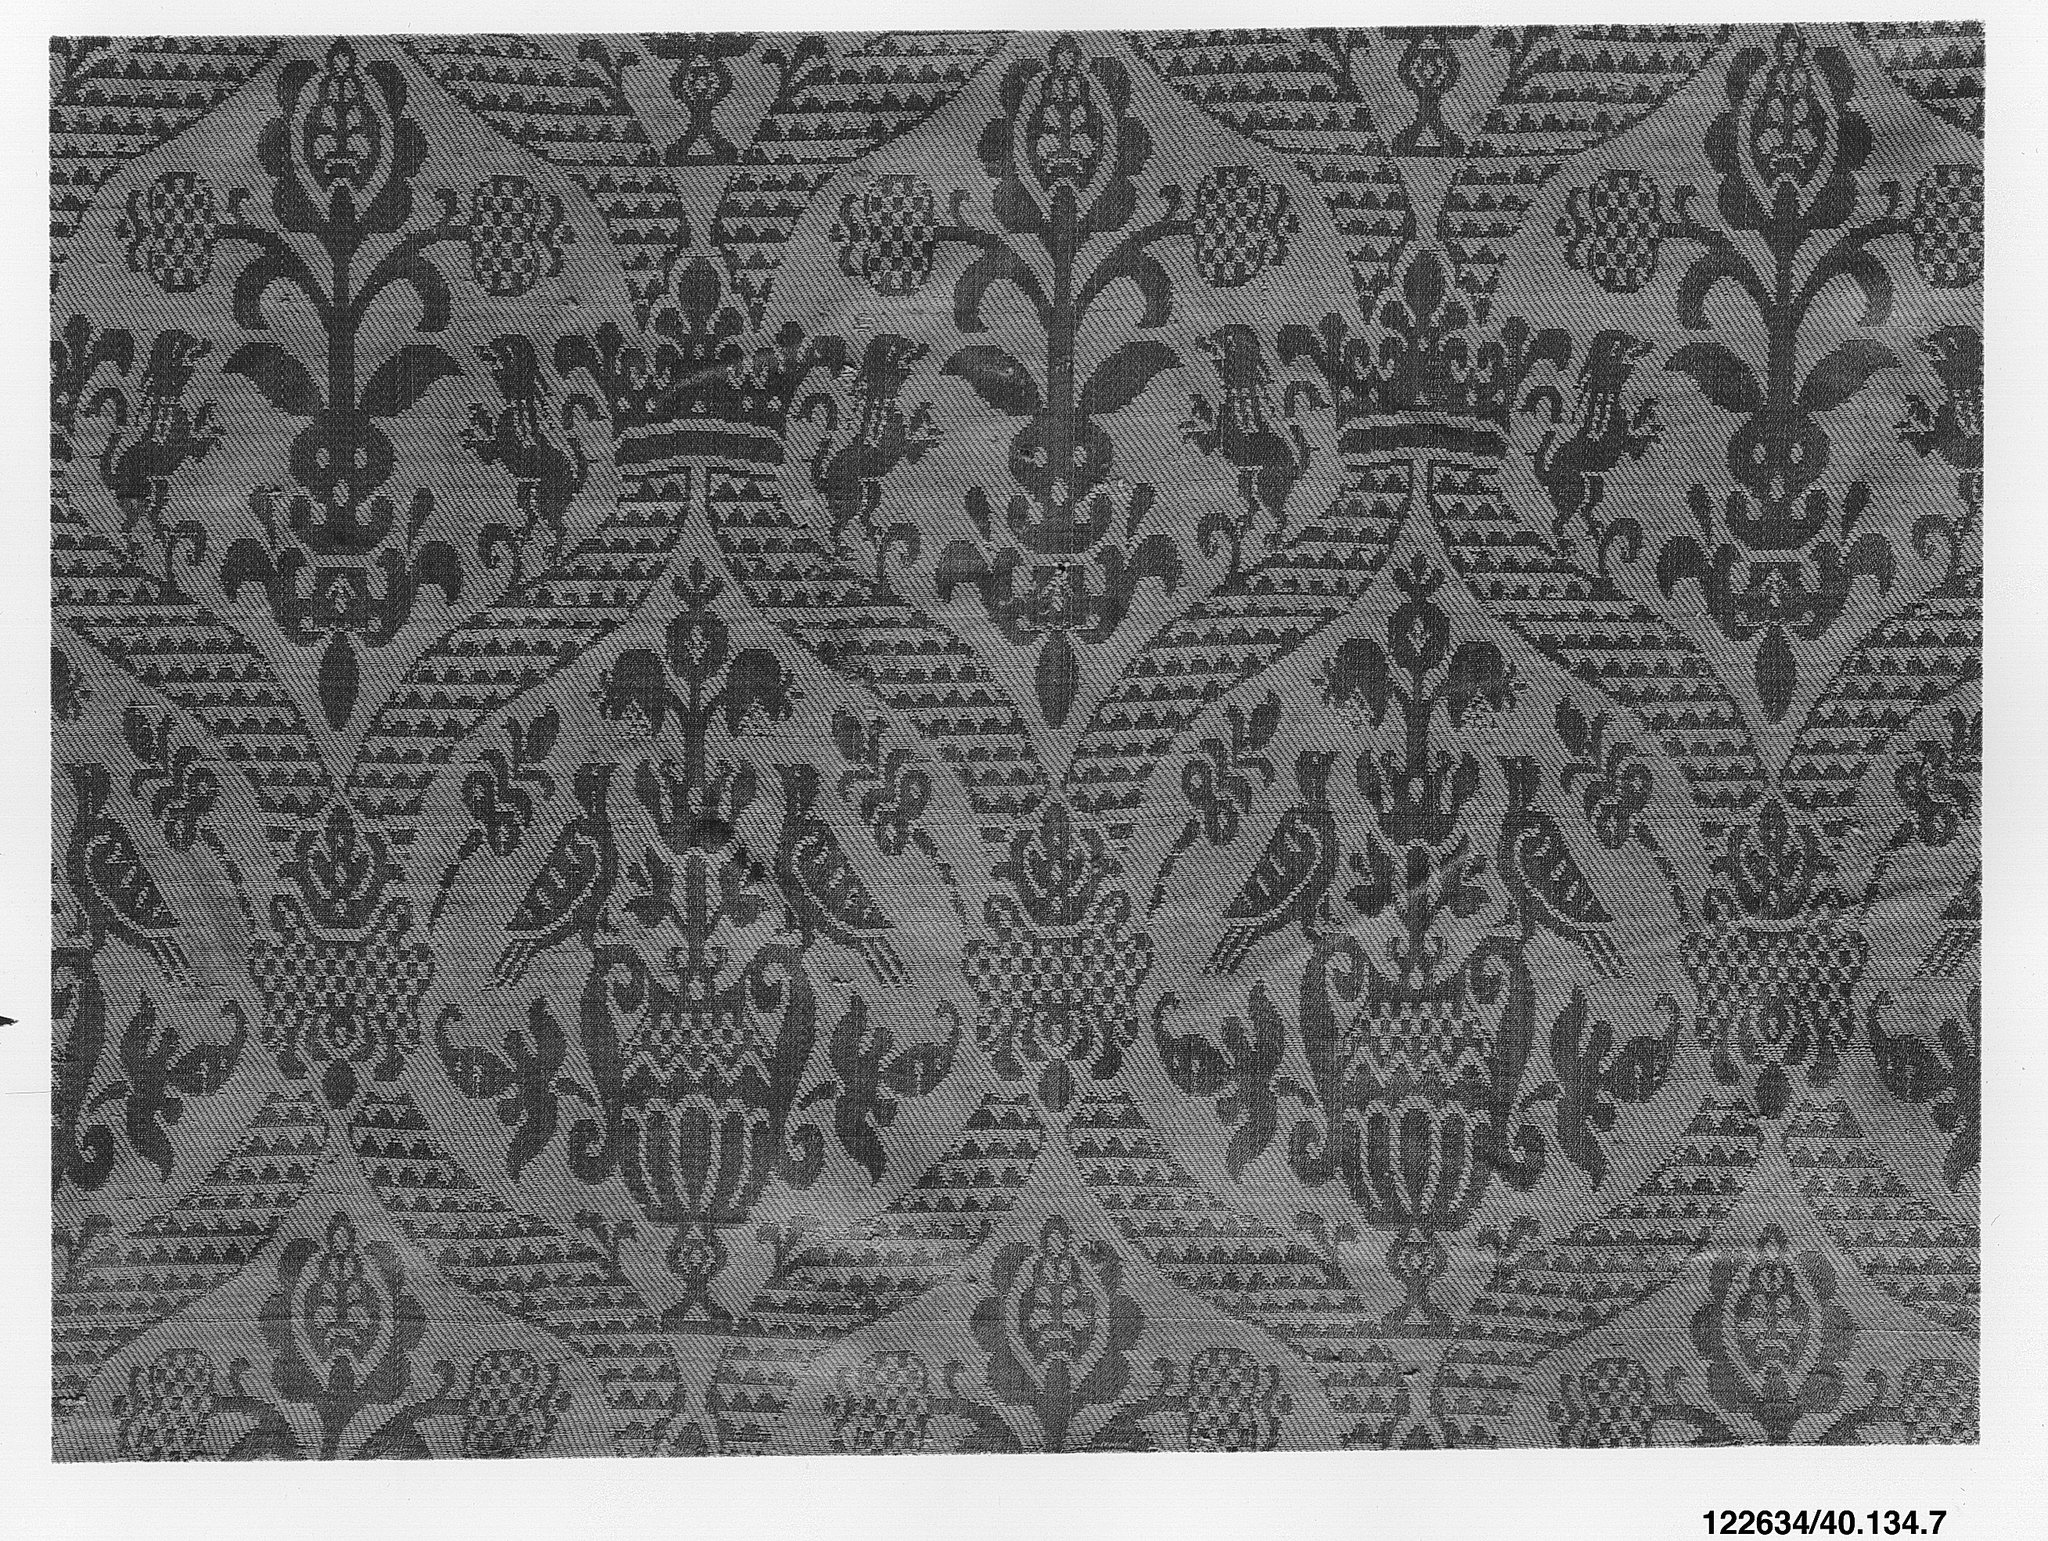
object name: piece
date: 1567-1600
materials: silk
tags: animals,birds